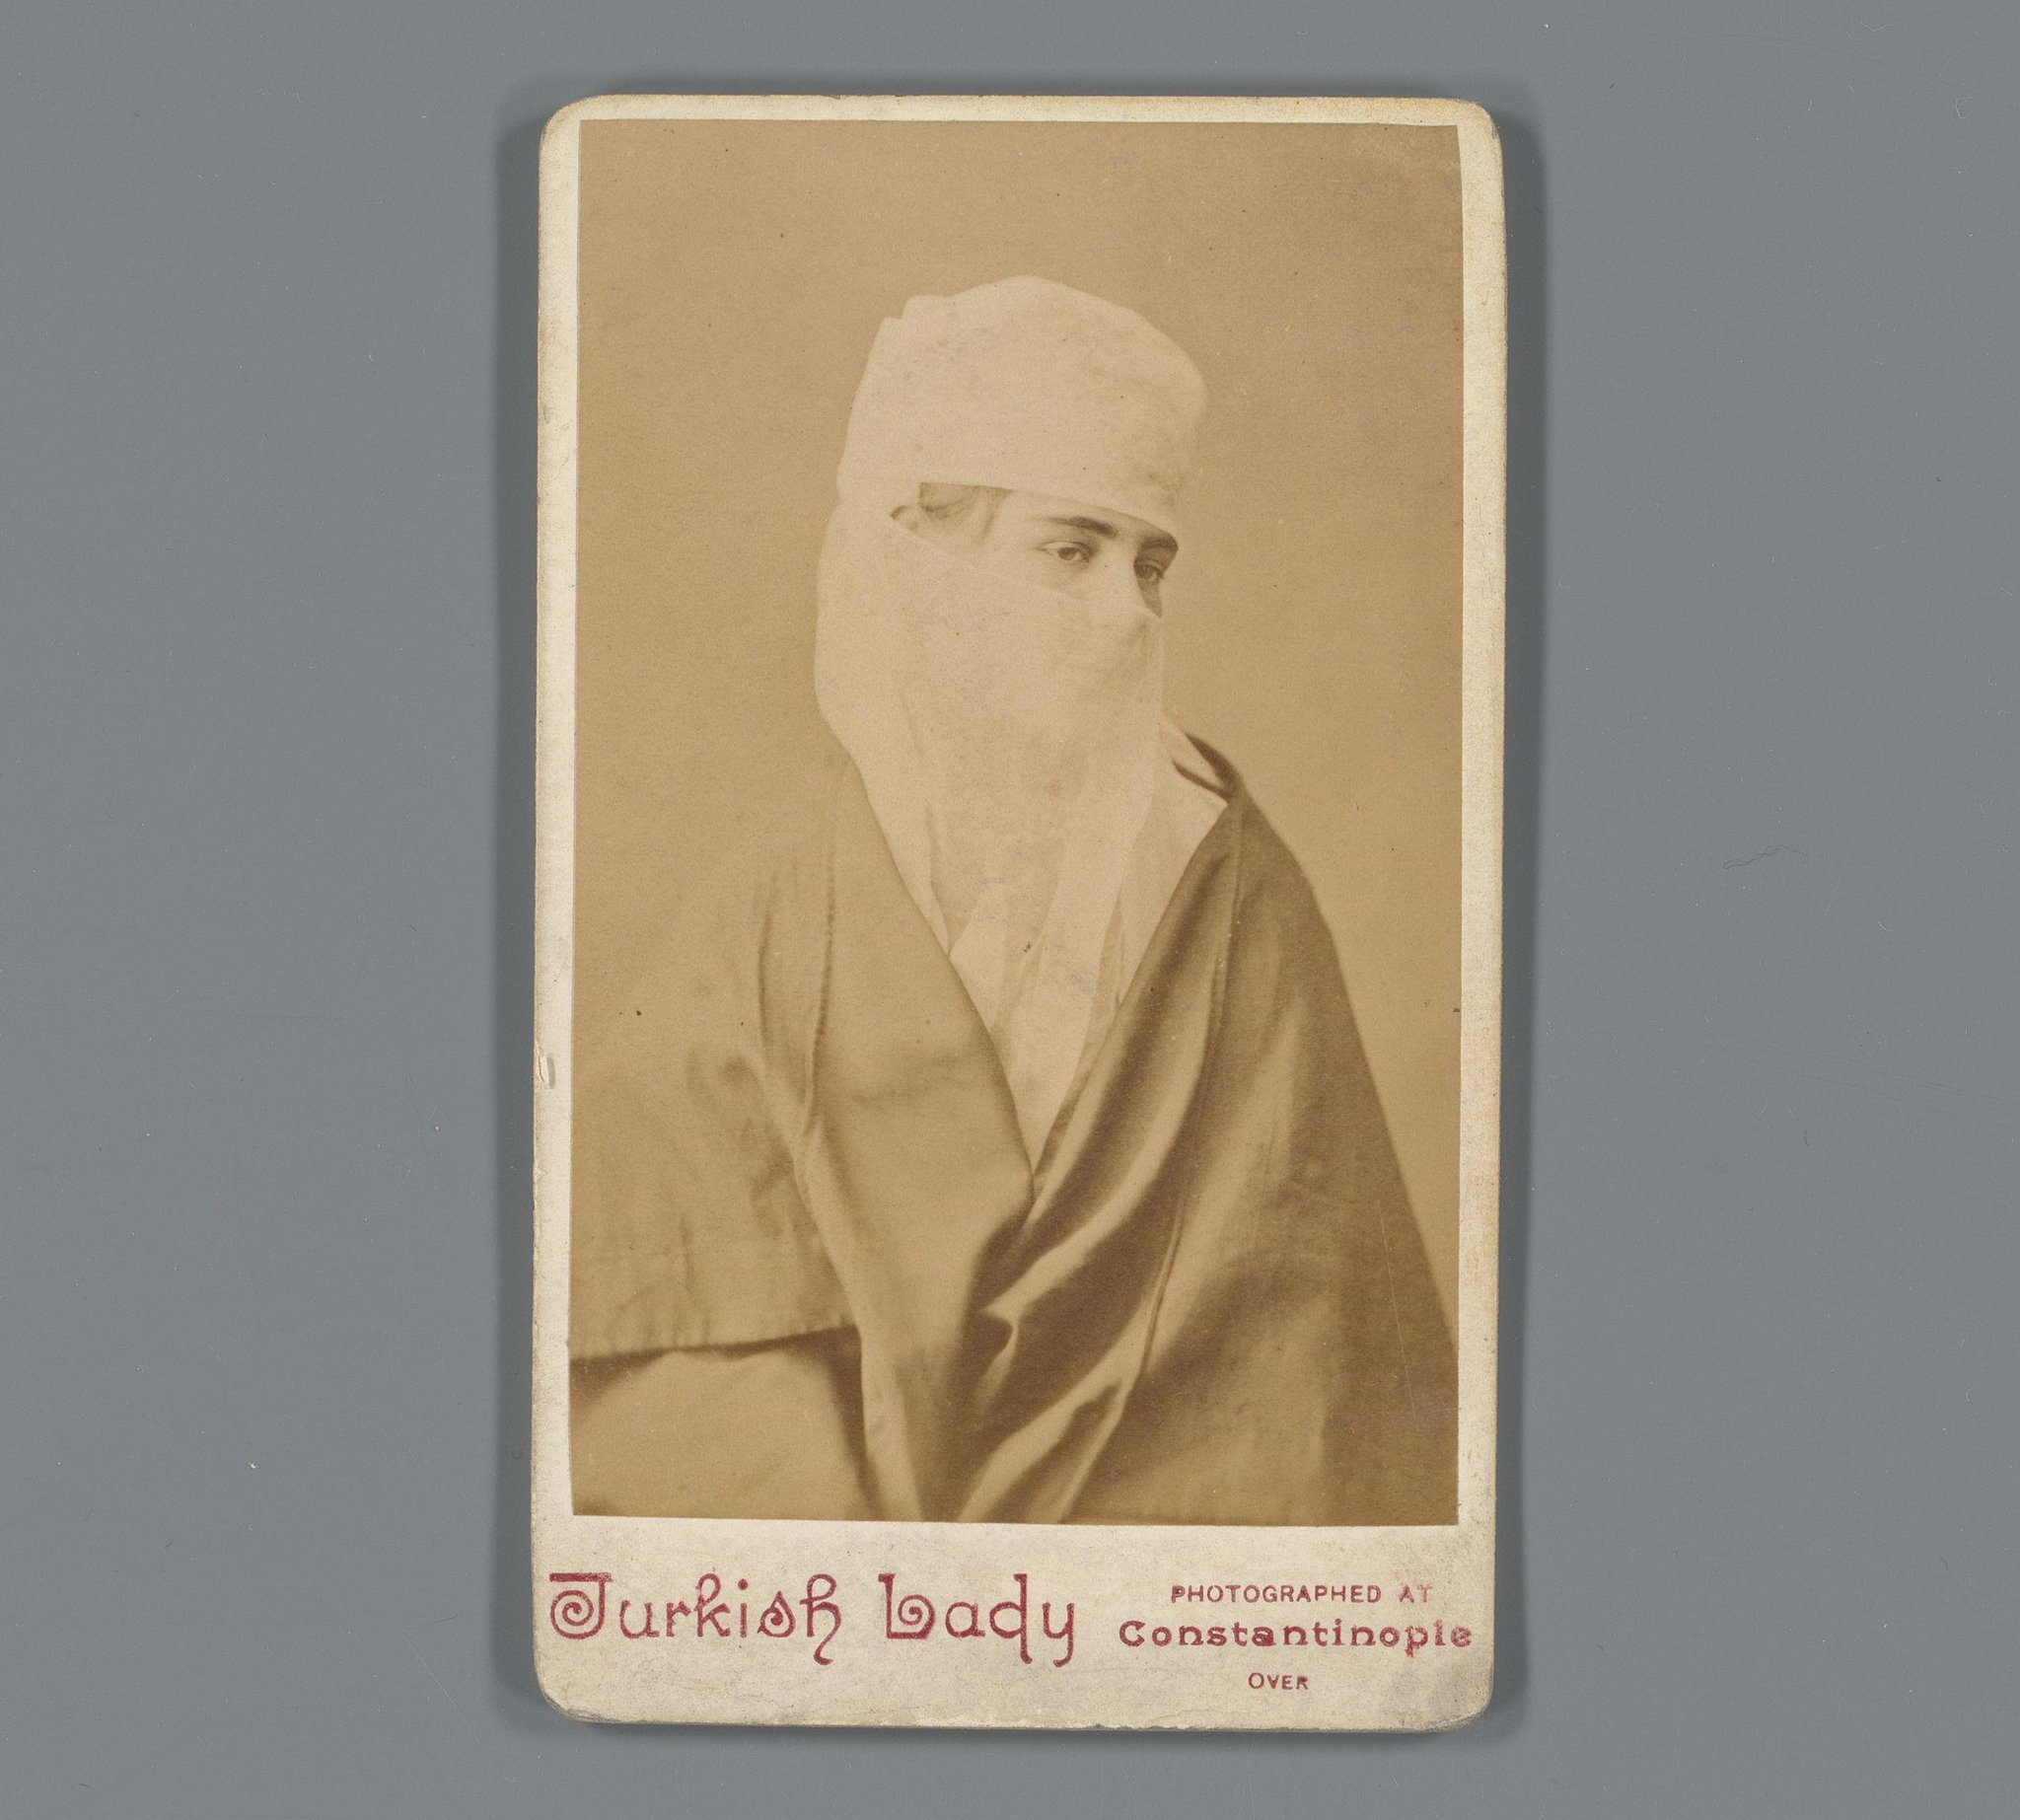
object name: photograph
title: Portret van een gesluierde vrouw in Constantinopel als reclame voor Turkse goederen van Bovee, Joy & Co. in San Francisco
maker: Anonymous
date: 1850-1915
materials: cardboard, photographic support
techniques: albumen print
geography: constantinople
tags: advertising, historical persons not known by name - bb - woman, covering the head, drawing drapery over the face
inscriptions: inscription: ‘ART ROOMS OF Bovee, Joy & Co./ 19 Montgomery Street/ AN FRANCISCO, OCTOBER 5, 1890./ (...)’